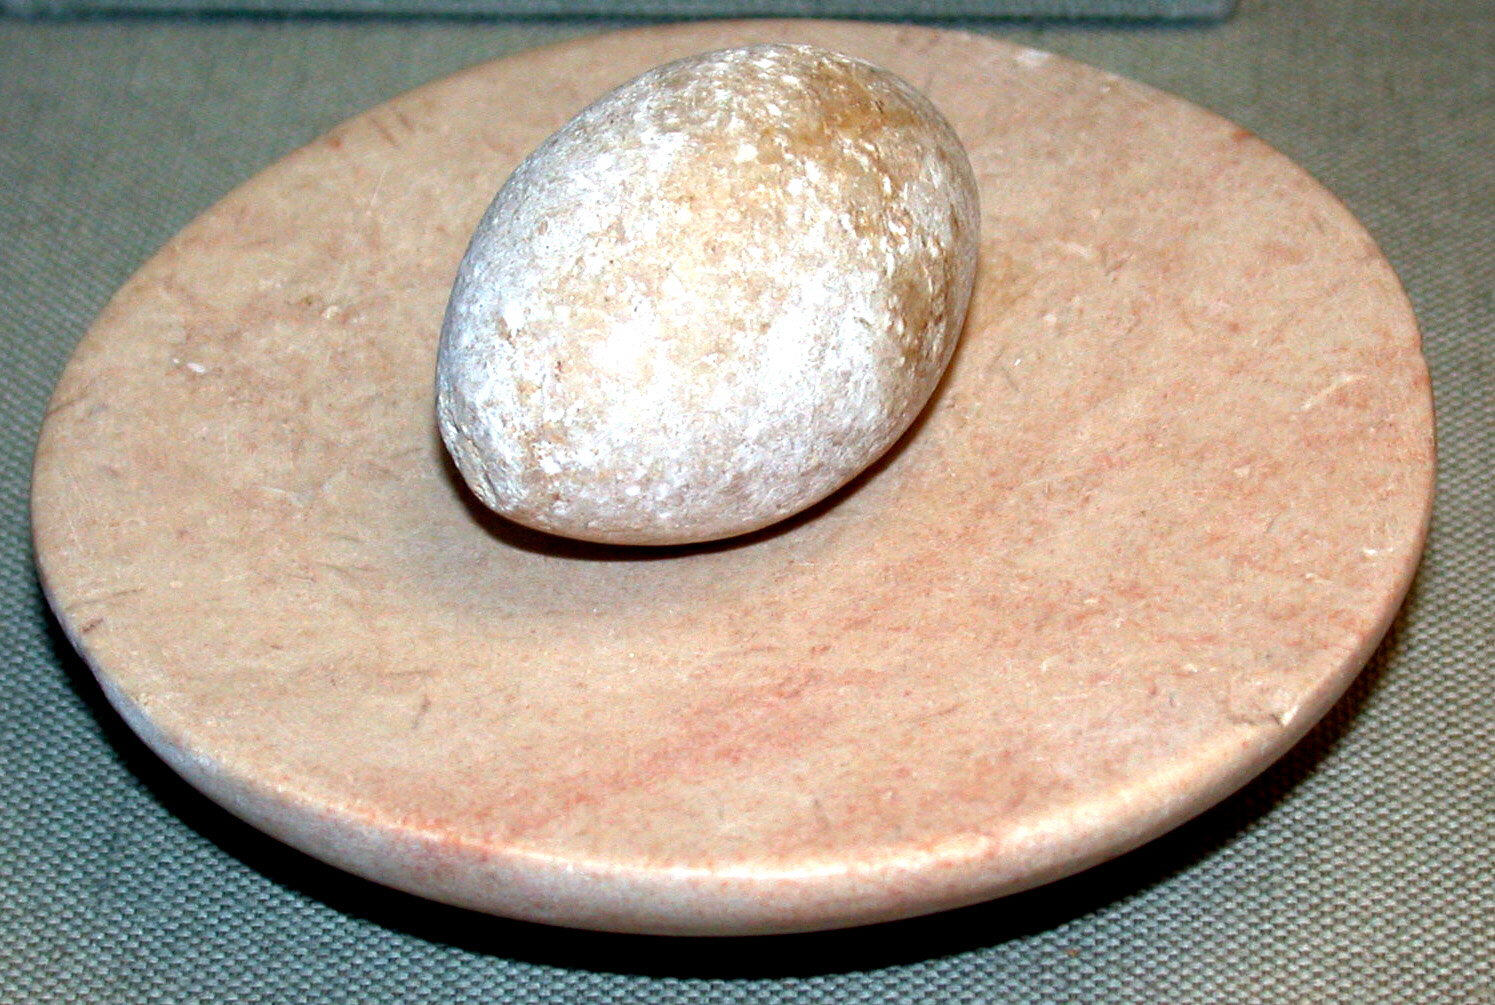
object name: pestle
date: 7333-7001 BCE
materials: limestone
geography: syria